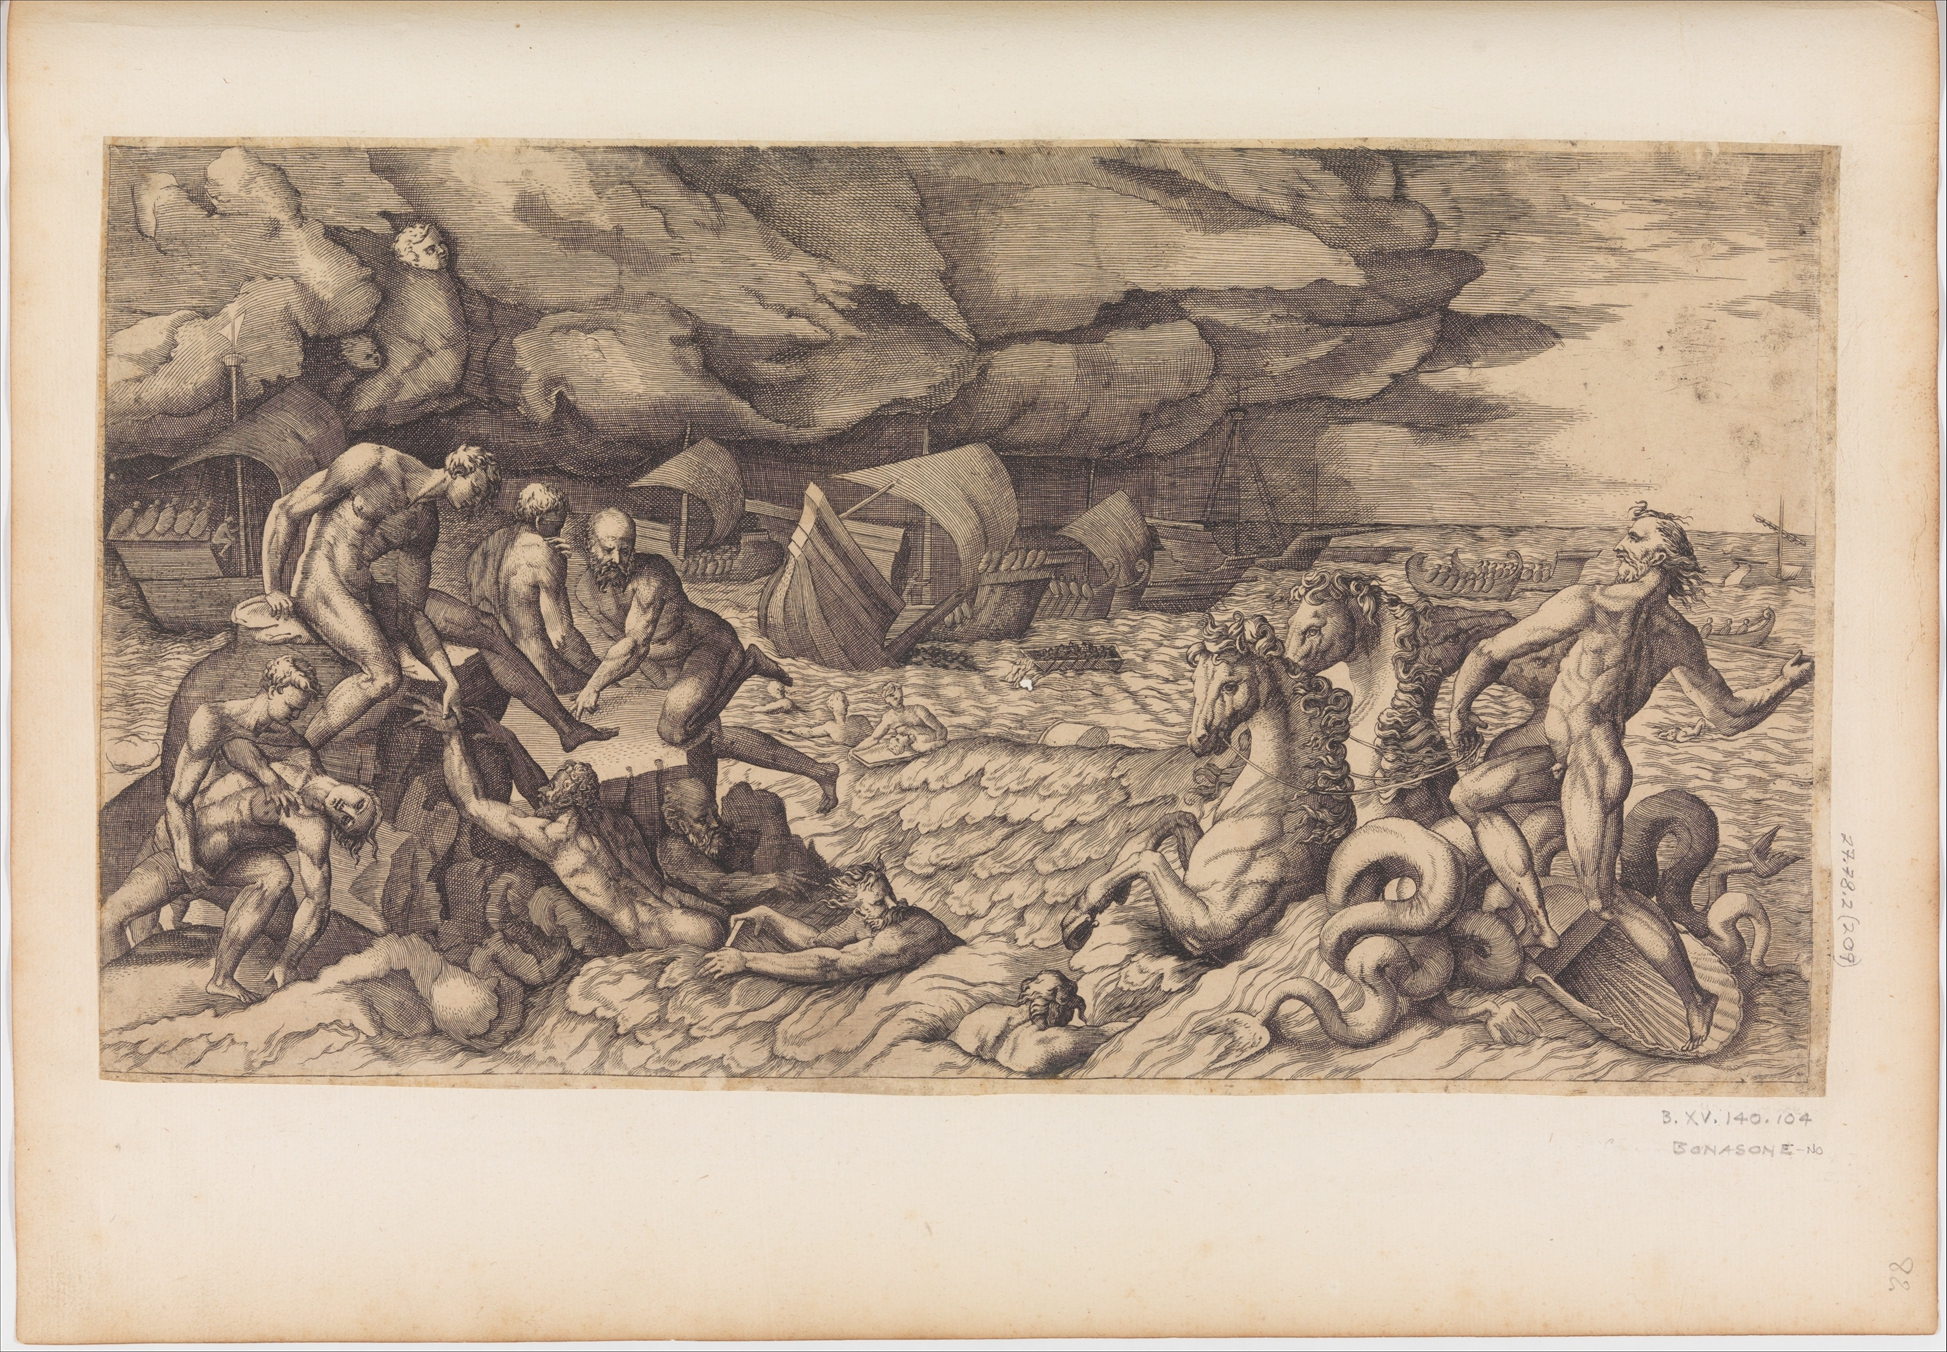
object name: print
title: Neptune Calming the Tempest Raised Against the Fleet of Aeneas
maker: giulio bonasone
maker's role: artist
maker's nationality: italian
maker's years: 1510-1576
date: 1510-1576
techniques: engraving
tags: male nudes,aeneas,neptune,horses,boats